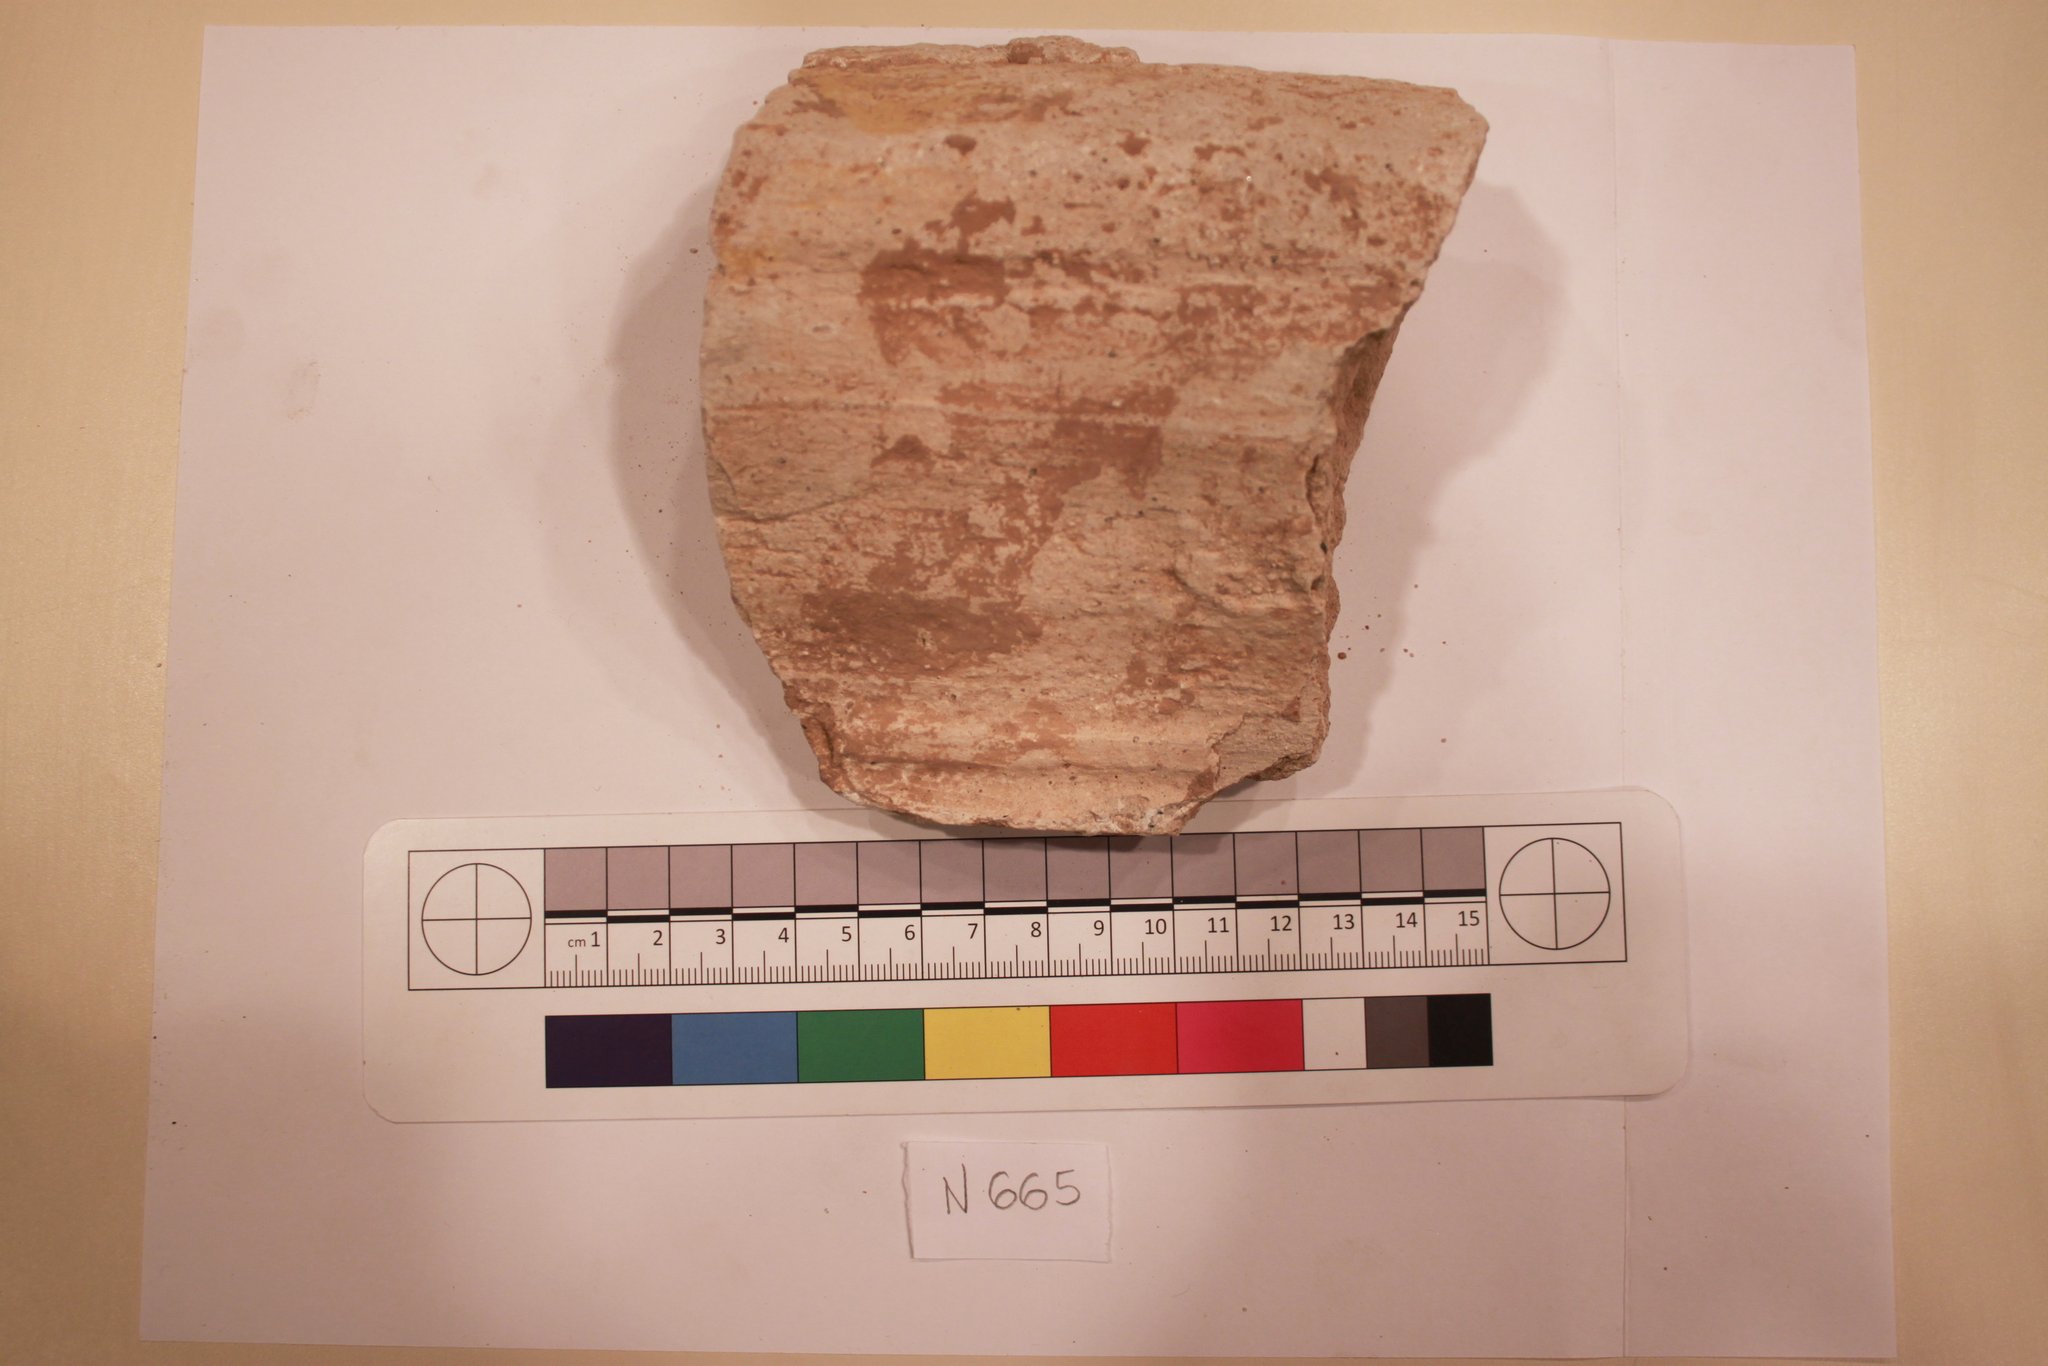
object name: fragment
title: Stucco Fragment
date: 701-1200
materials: plaster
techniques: carving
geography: iran